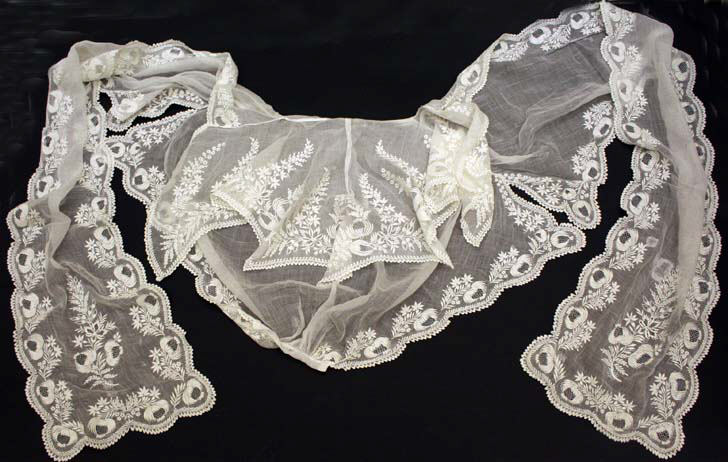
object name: pelerine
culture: european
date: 1825-1837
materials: cotton